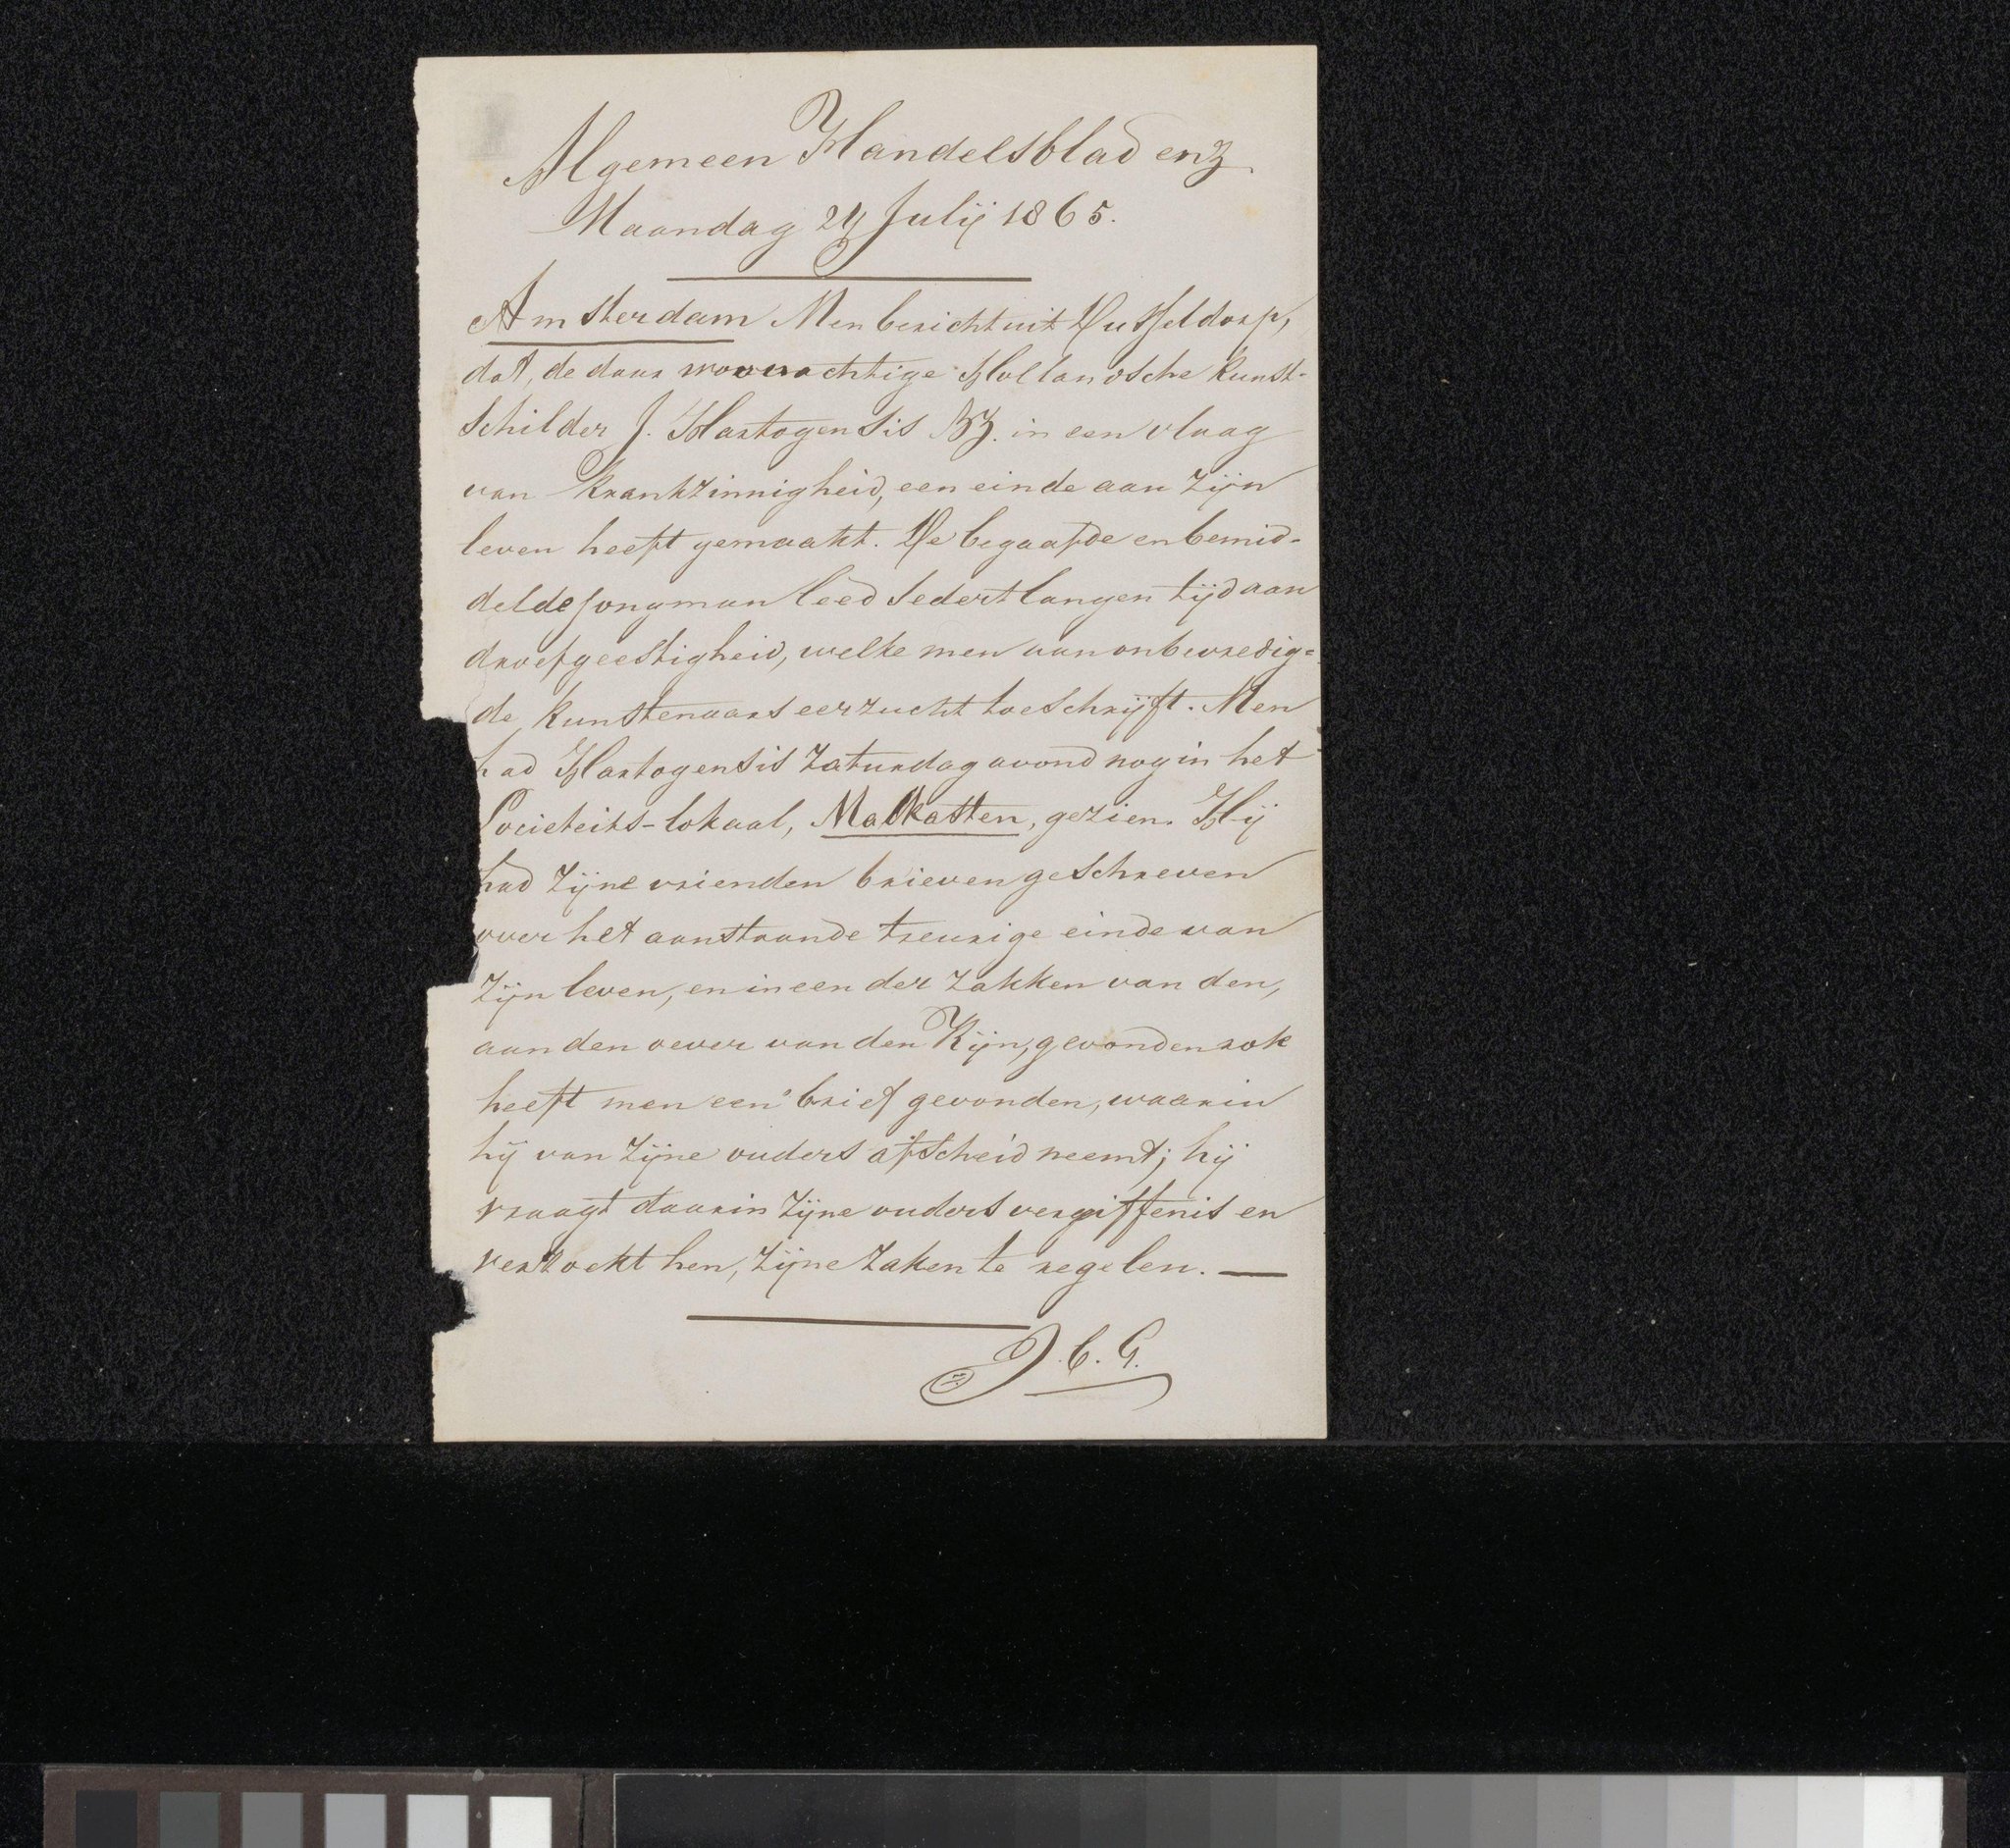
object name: newspaper clipping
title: Krantenknipsel betreffende Joseph Hartogensis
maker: Anonymous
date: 1865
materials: paper, ink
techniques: printing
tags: den bosch, painter, print maker, joseph hartogensis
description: Krantenknipsel bevat handgeschreven versie van het artikel.